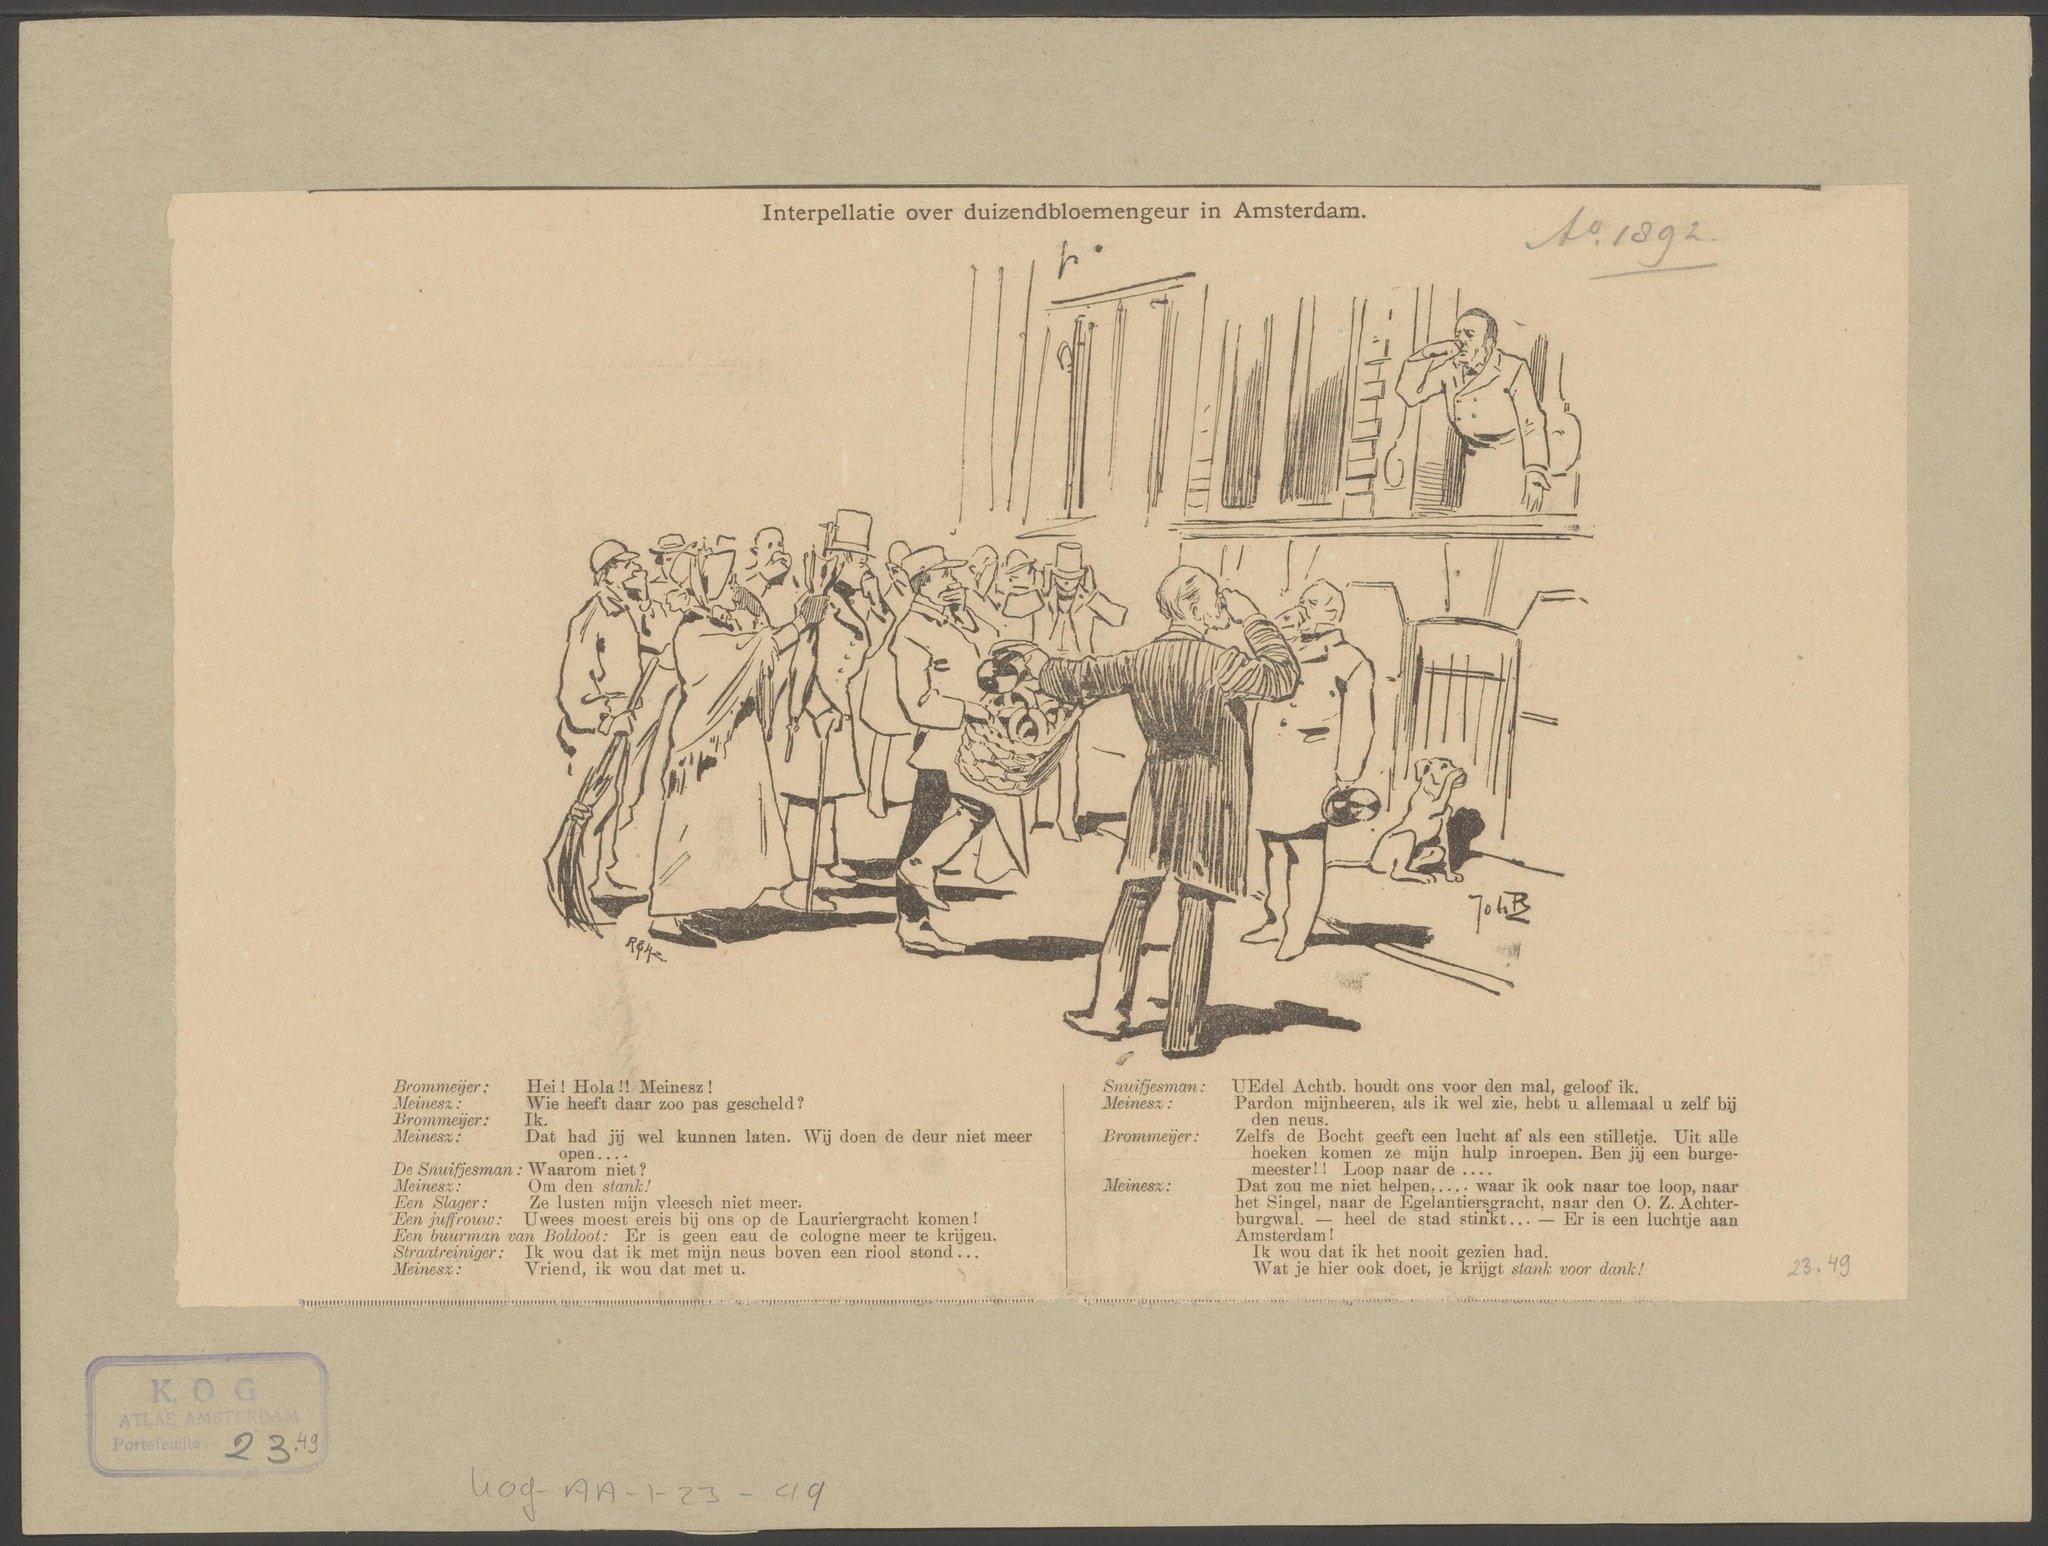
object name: cartoon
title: Interpellatie over duizendbloemengeur in Amsterdam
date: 1892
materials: paper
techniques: letterpress printing, line block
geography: netherlands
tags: harlingen, politician, crowd, mob, holding one's nose closed, political caricatures and satires, amsterdam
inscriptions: signature: ‘R&Hz.’, collector's mark: Lugt 1641b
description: Prent uit: De Amsterdammer 16 (1892), nr. 793, 4 september 1892, p. 7.